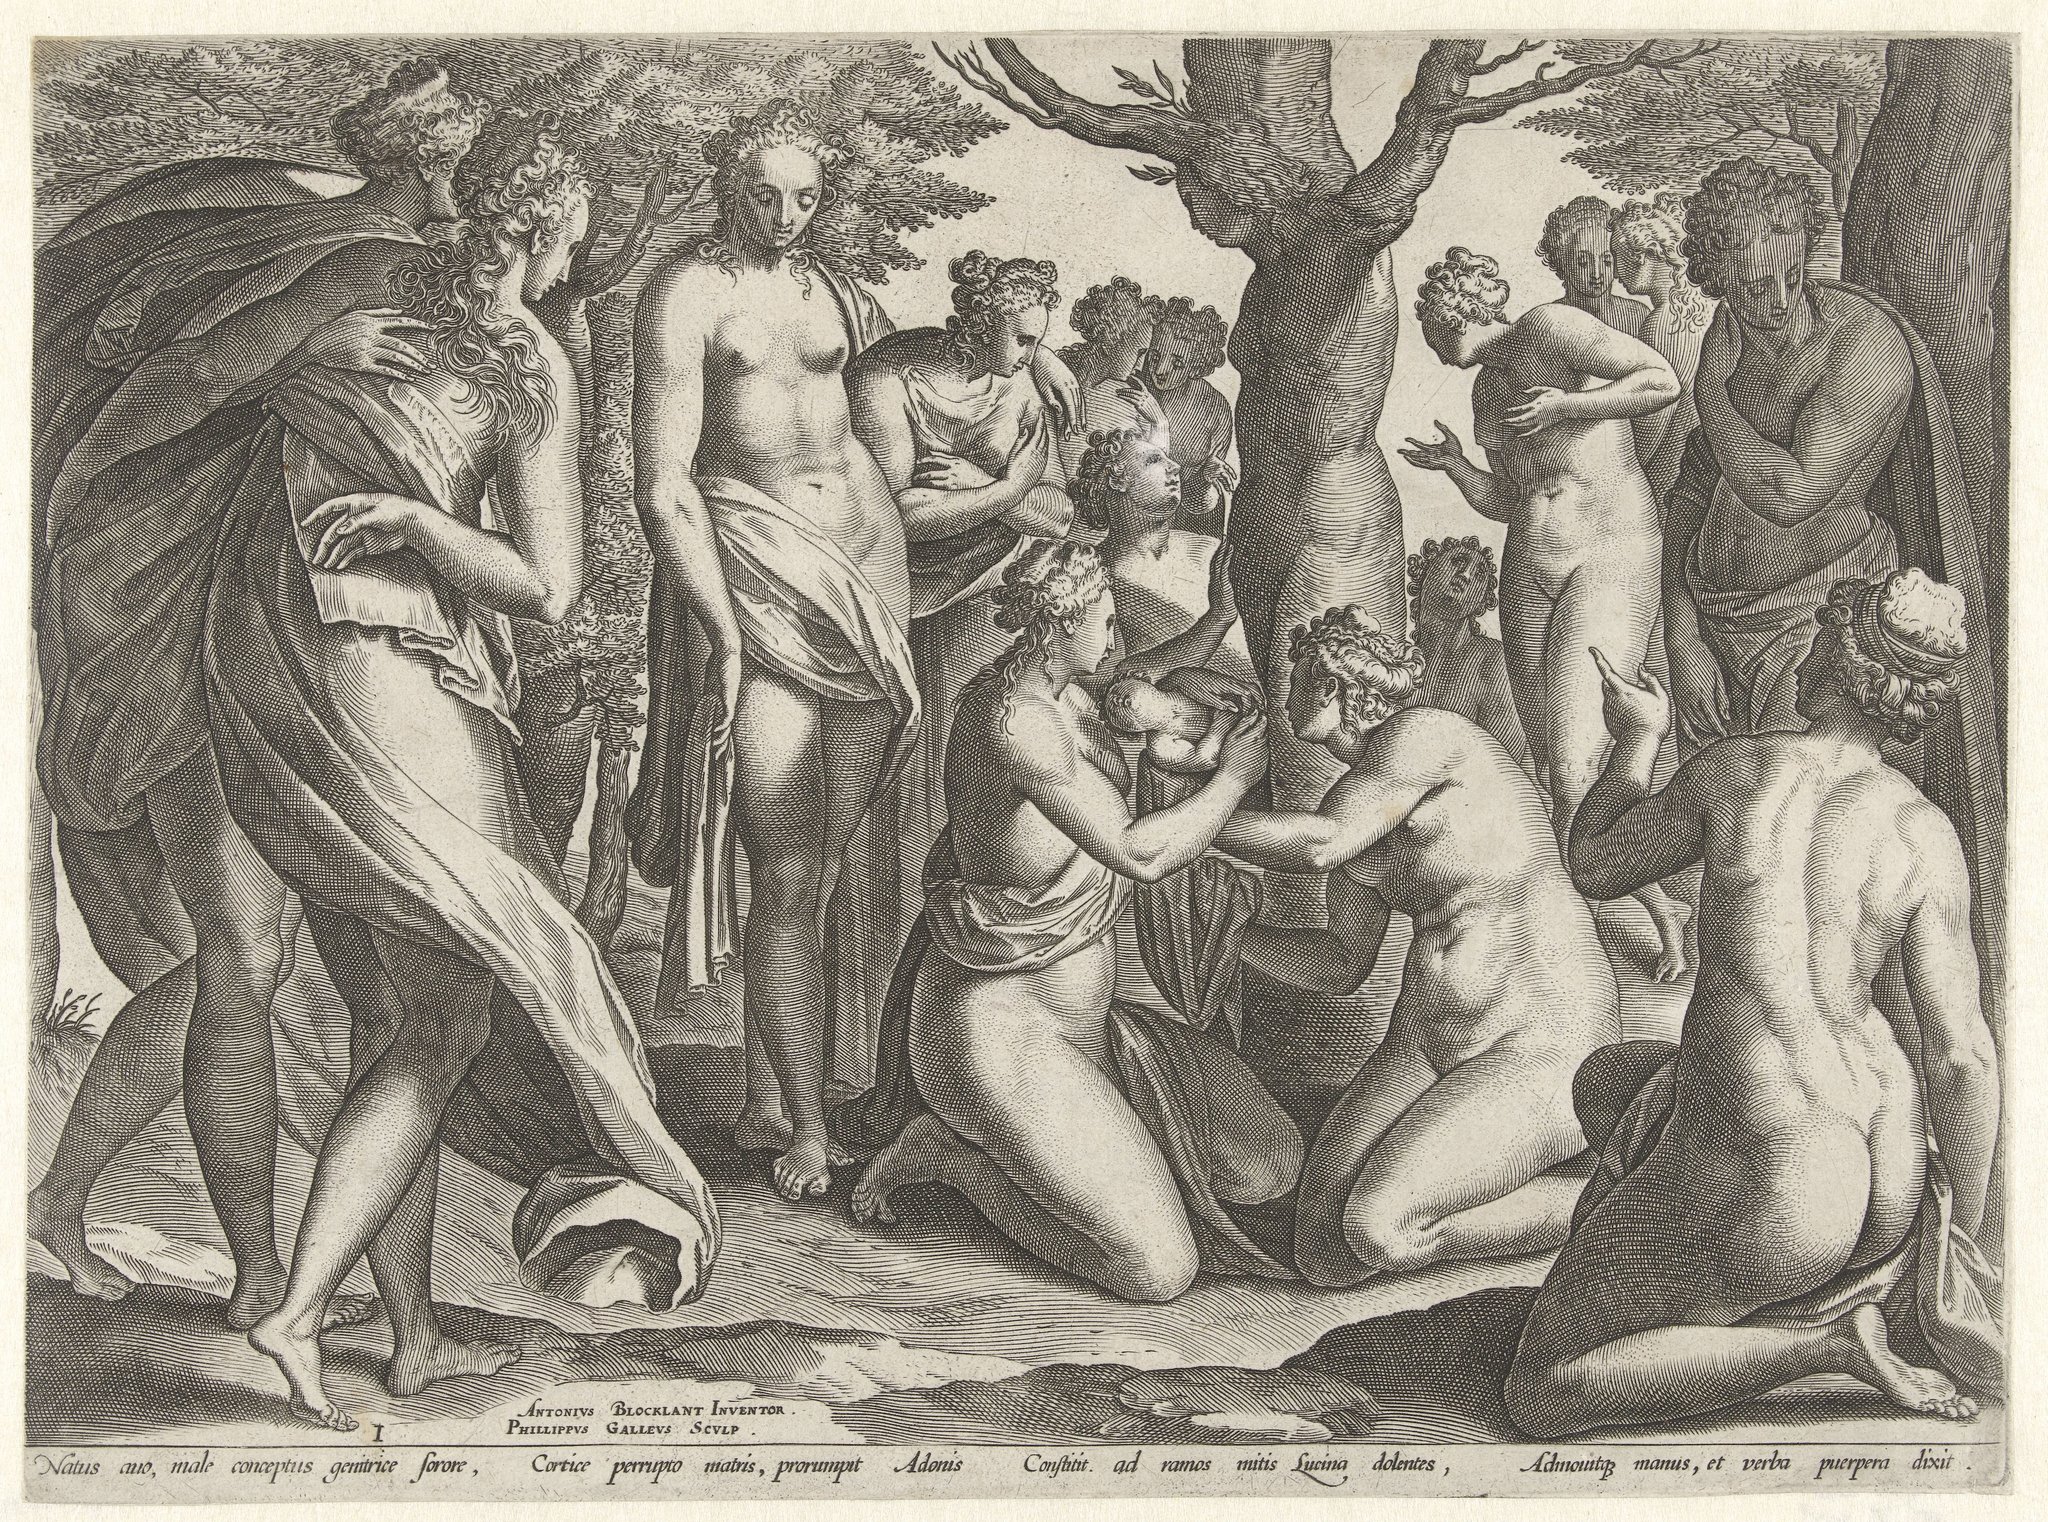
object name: print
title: Geboorte van Adonis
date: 1577-1581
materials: paper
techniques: engraving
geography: utrecht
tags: birth of adonis: the tree splits open to release the baby; the naiads take care of him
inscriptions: collector's mark: Lugt 2760, collector's mark: Lugt 2228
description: Adonis, de zoon van Myrrha en haar vader Cinyras, wordt geboren uit de stam van een boom. Zijn moeder werd tijdens haar zwangerschap namelijk op haar eigen verzoek in een mirreboom veranderd. De nimfen van het woud helpen bij de geboorte. De prent heeft een Latijns onderschrift en maakt deel uit van een serie over Adonis' leven.